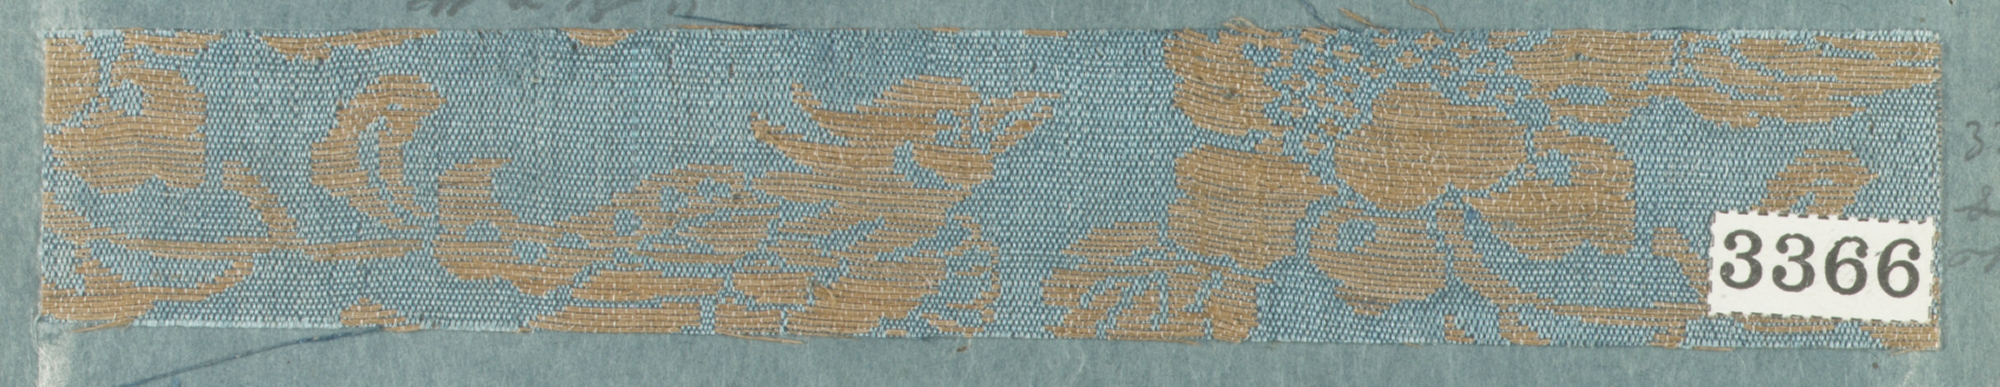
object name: textile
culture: japanese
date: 1801-1900